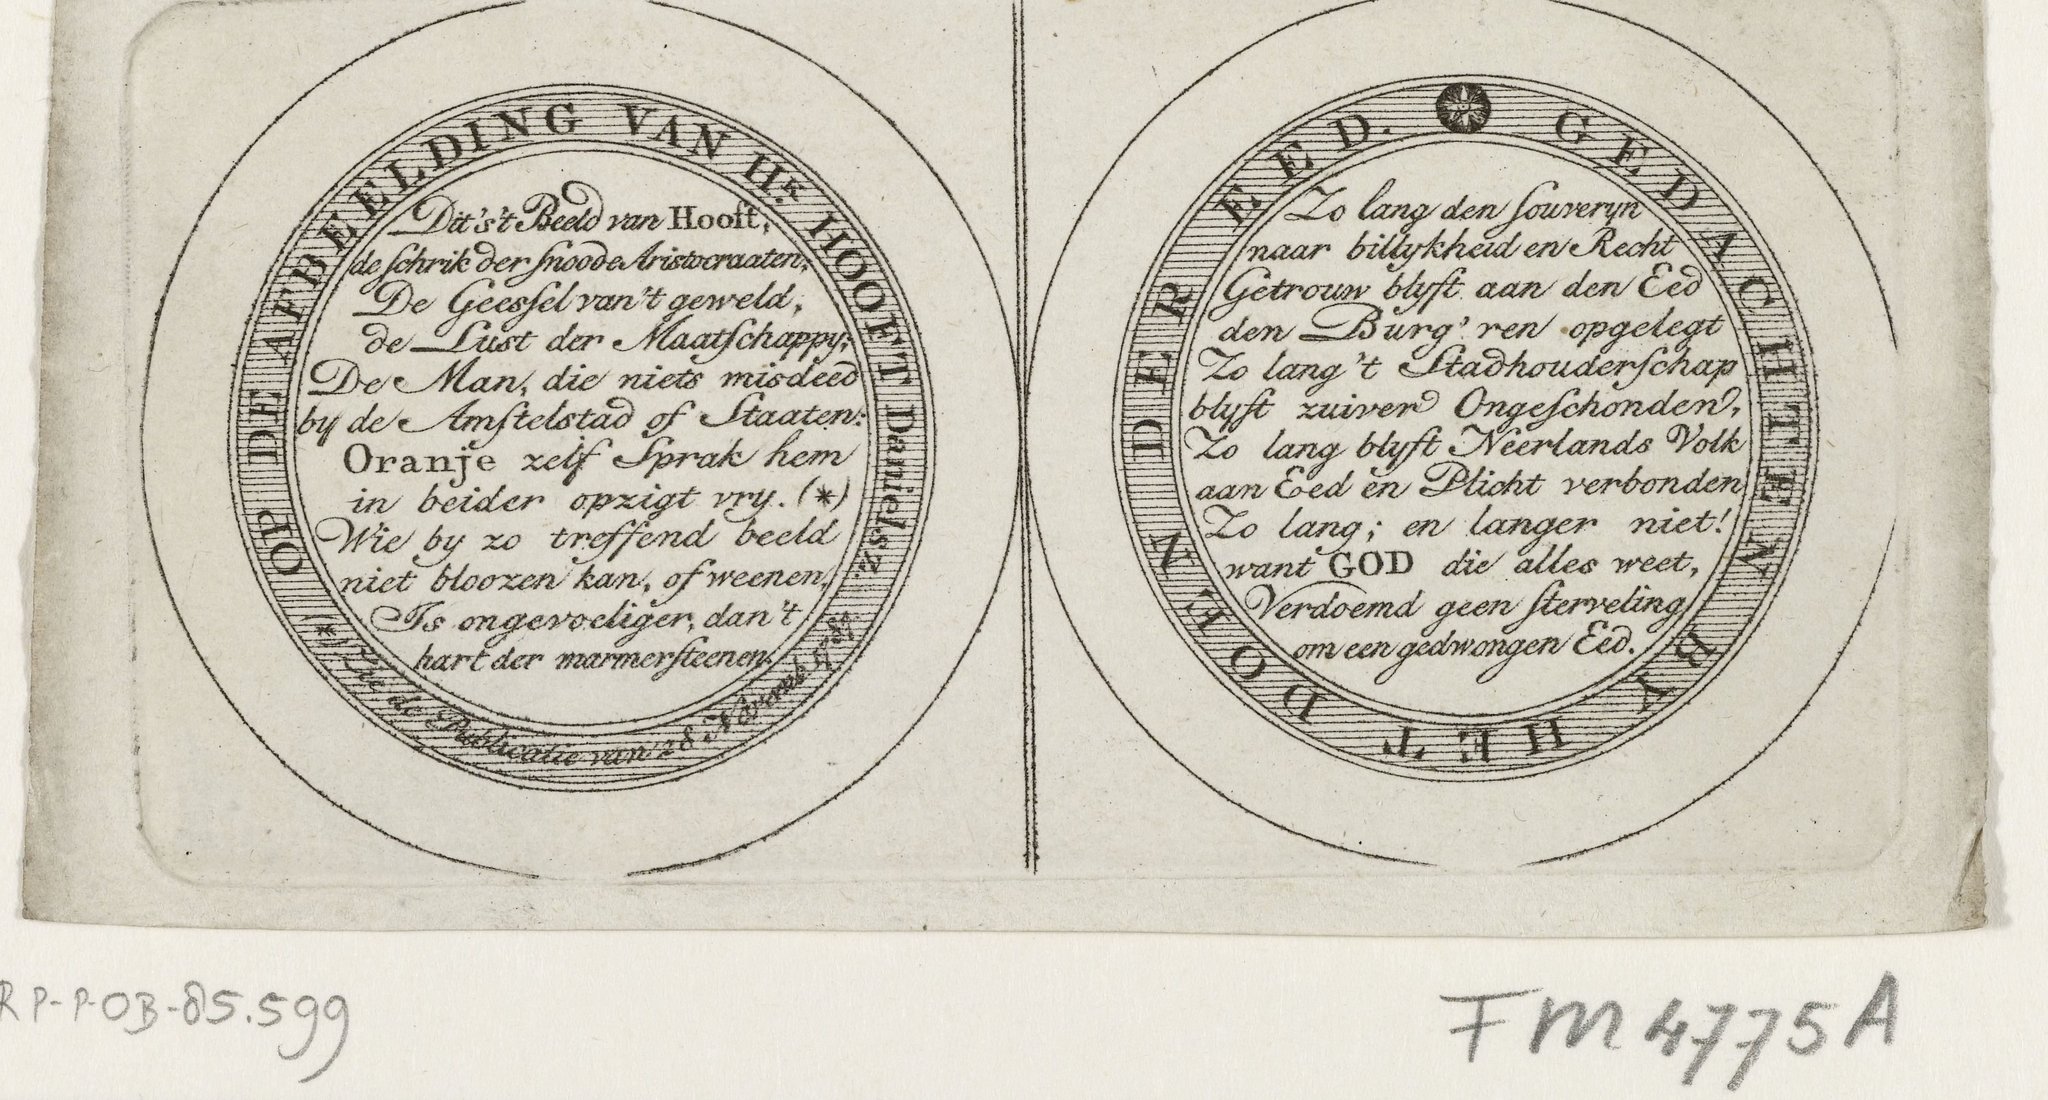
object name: print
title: Op de Afbeelding van Hk. Hooft Danielsz. / Gedachten by het doen der eed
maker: Anonymous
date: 1787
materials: paper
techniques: engraving, etching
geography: northern netherlands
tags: amsterdam, mayor, hendrik danielsz. hooft, medal (considered as a piece of sculpture, regardless of its specific function), patriots (1780-1795)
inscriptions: collector's mark: Lugt 2228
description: Beide zijden van een penning met opschriften ter ere van de Amsterdamse burgemeester Hendrik Danielsz. Hooft, met een verwijzing naar een publicatie van 28 november 1787.